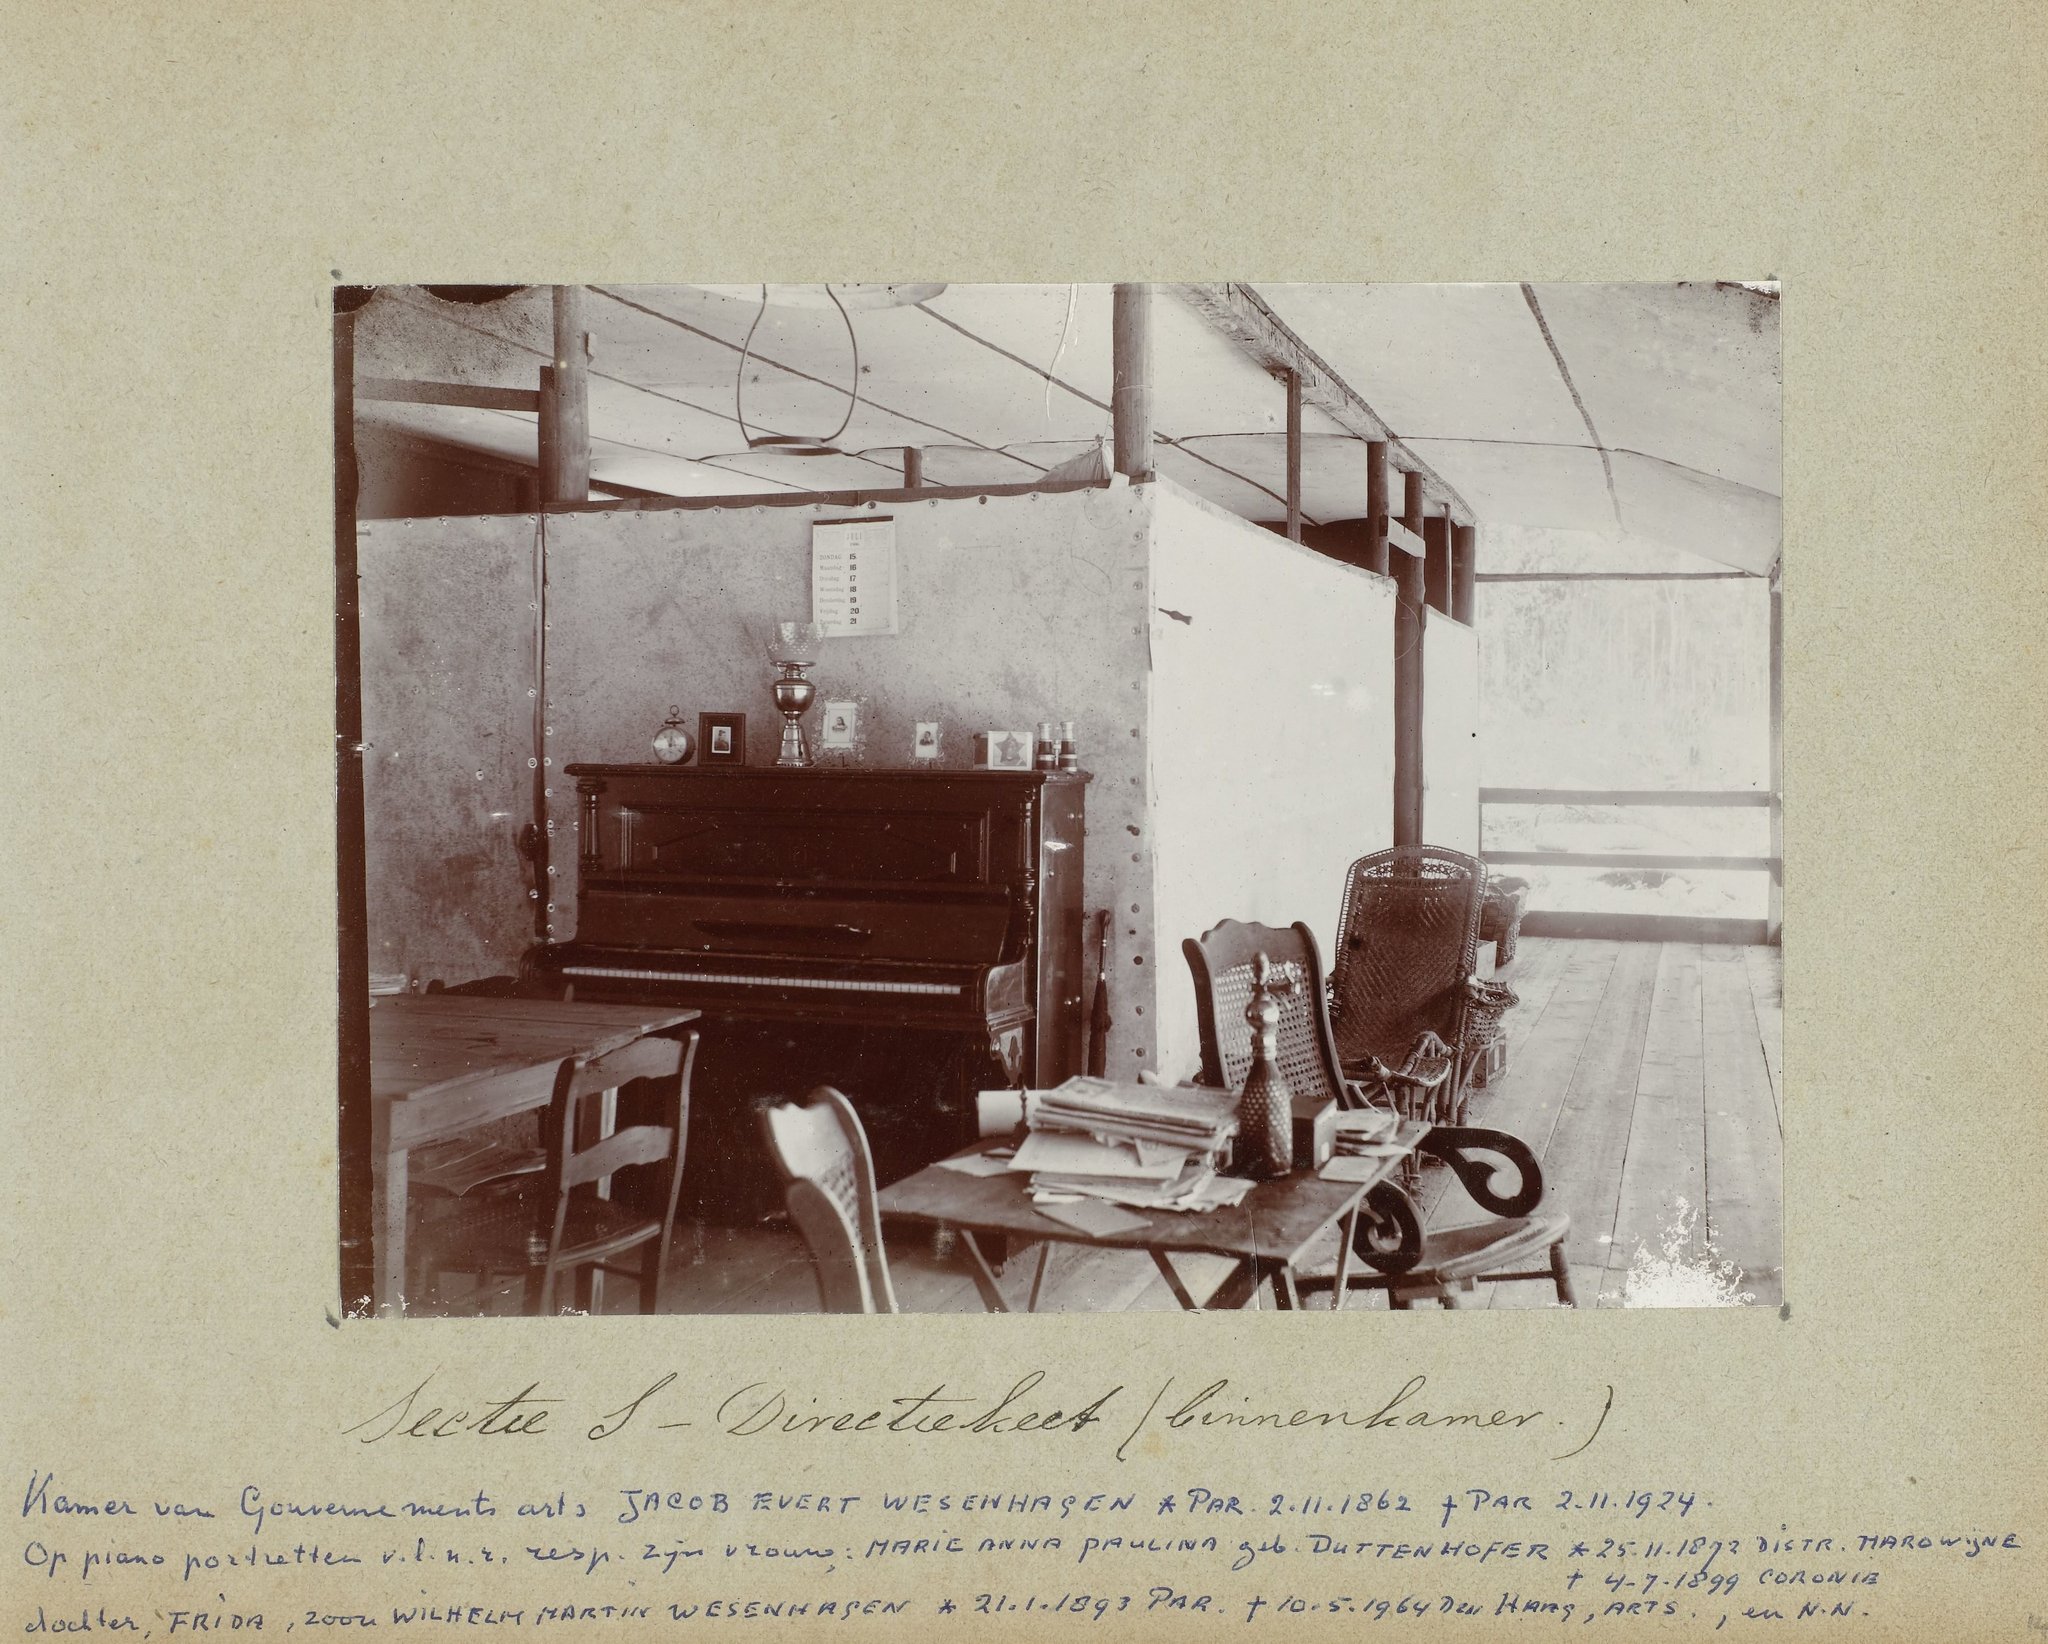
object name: photograph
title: Sectie S - Directiekeet (binnenkamer)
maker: augusta curiel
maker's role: fotograaf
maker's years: 1873-1937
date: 1905-1910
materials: photographic support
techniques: photography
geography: suriname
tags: jacob evert wesenhagen, railway, tramway; rack railway, suriname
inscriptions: inscription: ‘Sectie S - Directiekeet (binnenkamer). / Kamer van Gouvernements arts Jacob Evert Wesenhagen ... Op piano portretten v.l.n.r resp. zijn vrouw Marie Anna Paulina ... dochter Frida ... zoon Wilhelm Martin’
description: Kamer van Jacob Evert Wesenhagen in de directiekeet in sectie S. Foto in het fotoalbum over de aanleg van de Lawaspoorweg in Suriname in de jaren 1903-1912. Onderdeel van een groep objecten afkomstig van de familie Wesenhagen in Suriname.